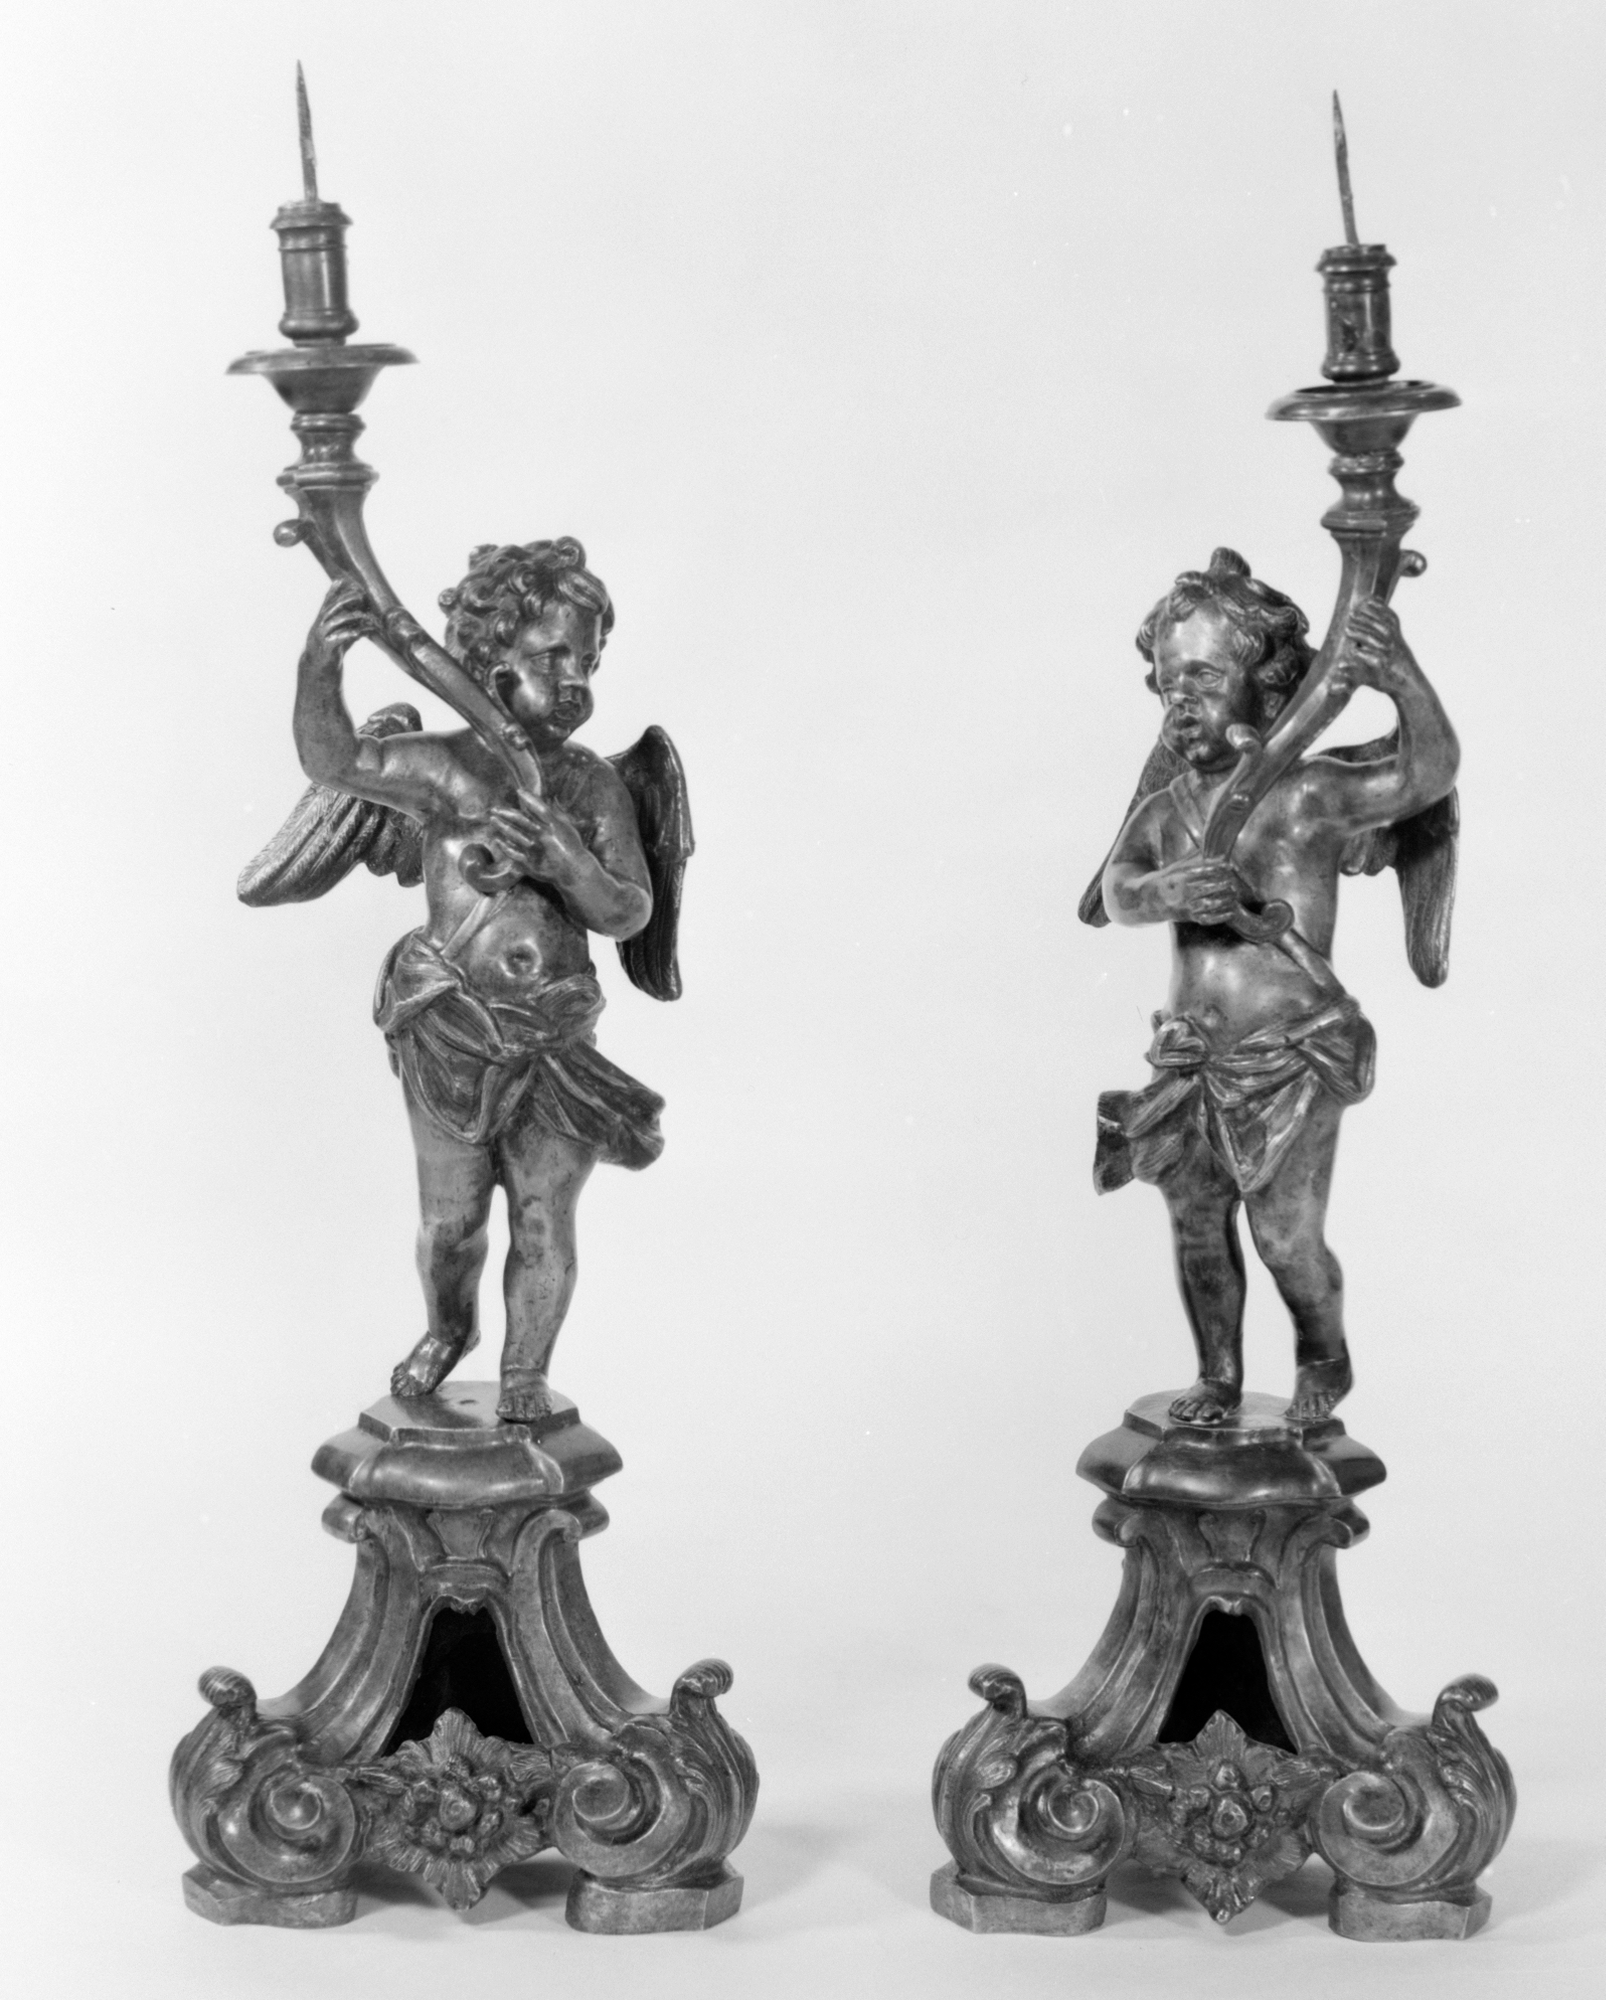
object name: candlestick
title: Pair of candlesticks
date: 1601-1700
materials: bronze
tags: cupid